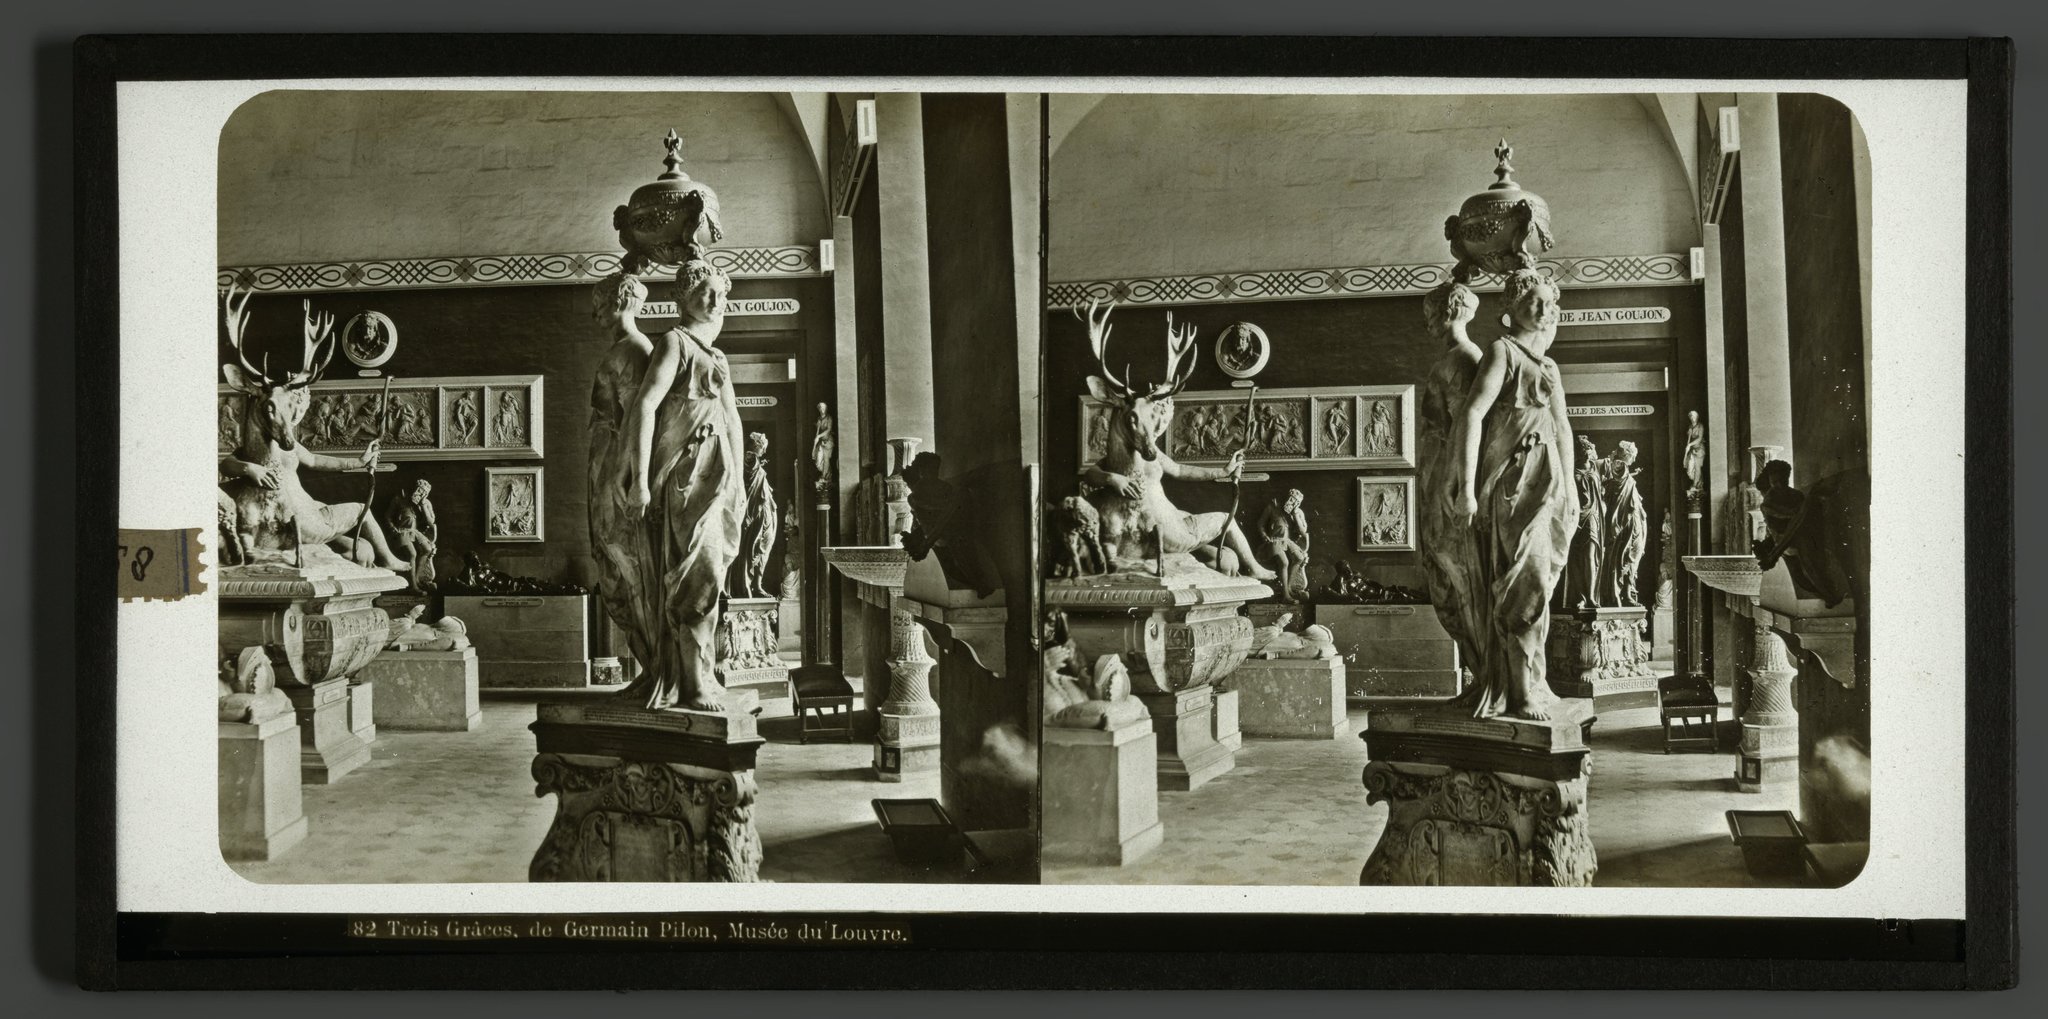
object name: stereoscopic photograph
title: Trois Grâces, de Germain Pilon, Musée du Louvre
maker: Anonymous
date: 1856-1890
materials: glass, paper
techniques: slide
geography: louvre museum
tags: graces (charites), generally three in number; 'gratie' (ripa), piece of sculpture, reproduction of a piece of sculpture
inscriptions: number: ‘82’, number: ‘58’